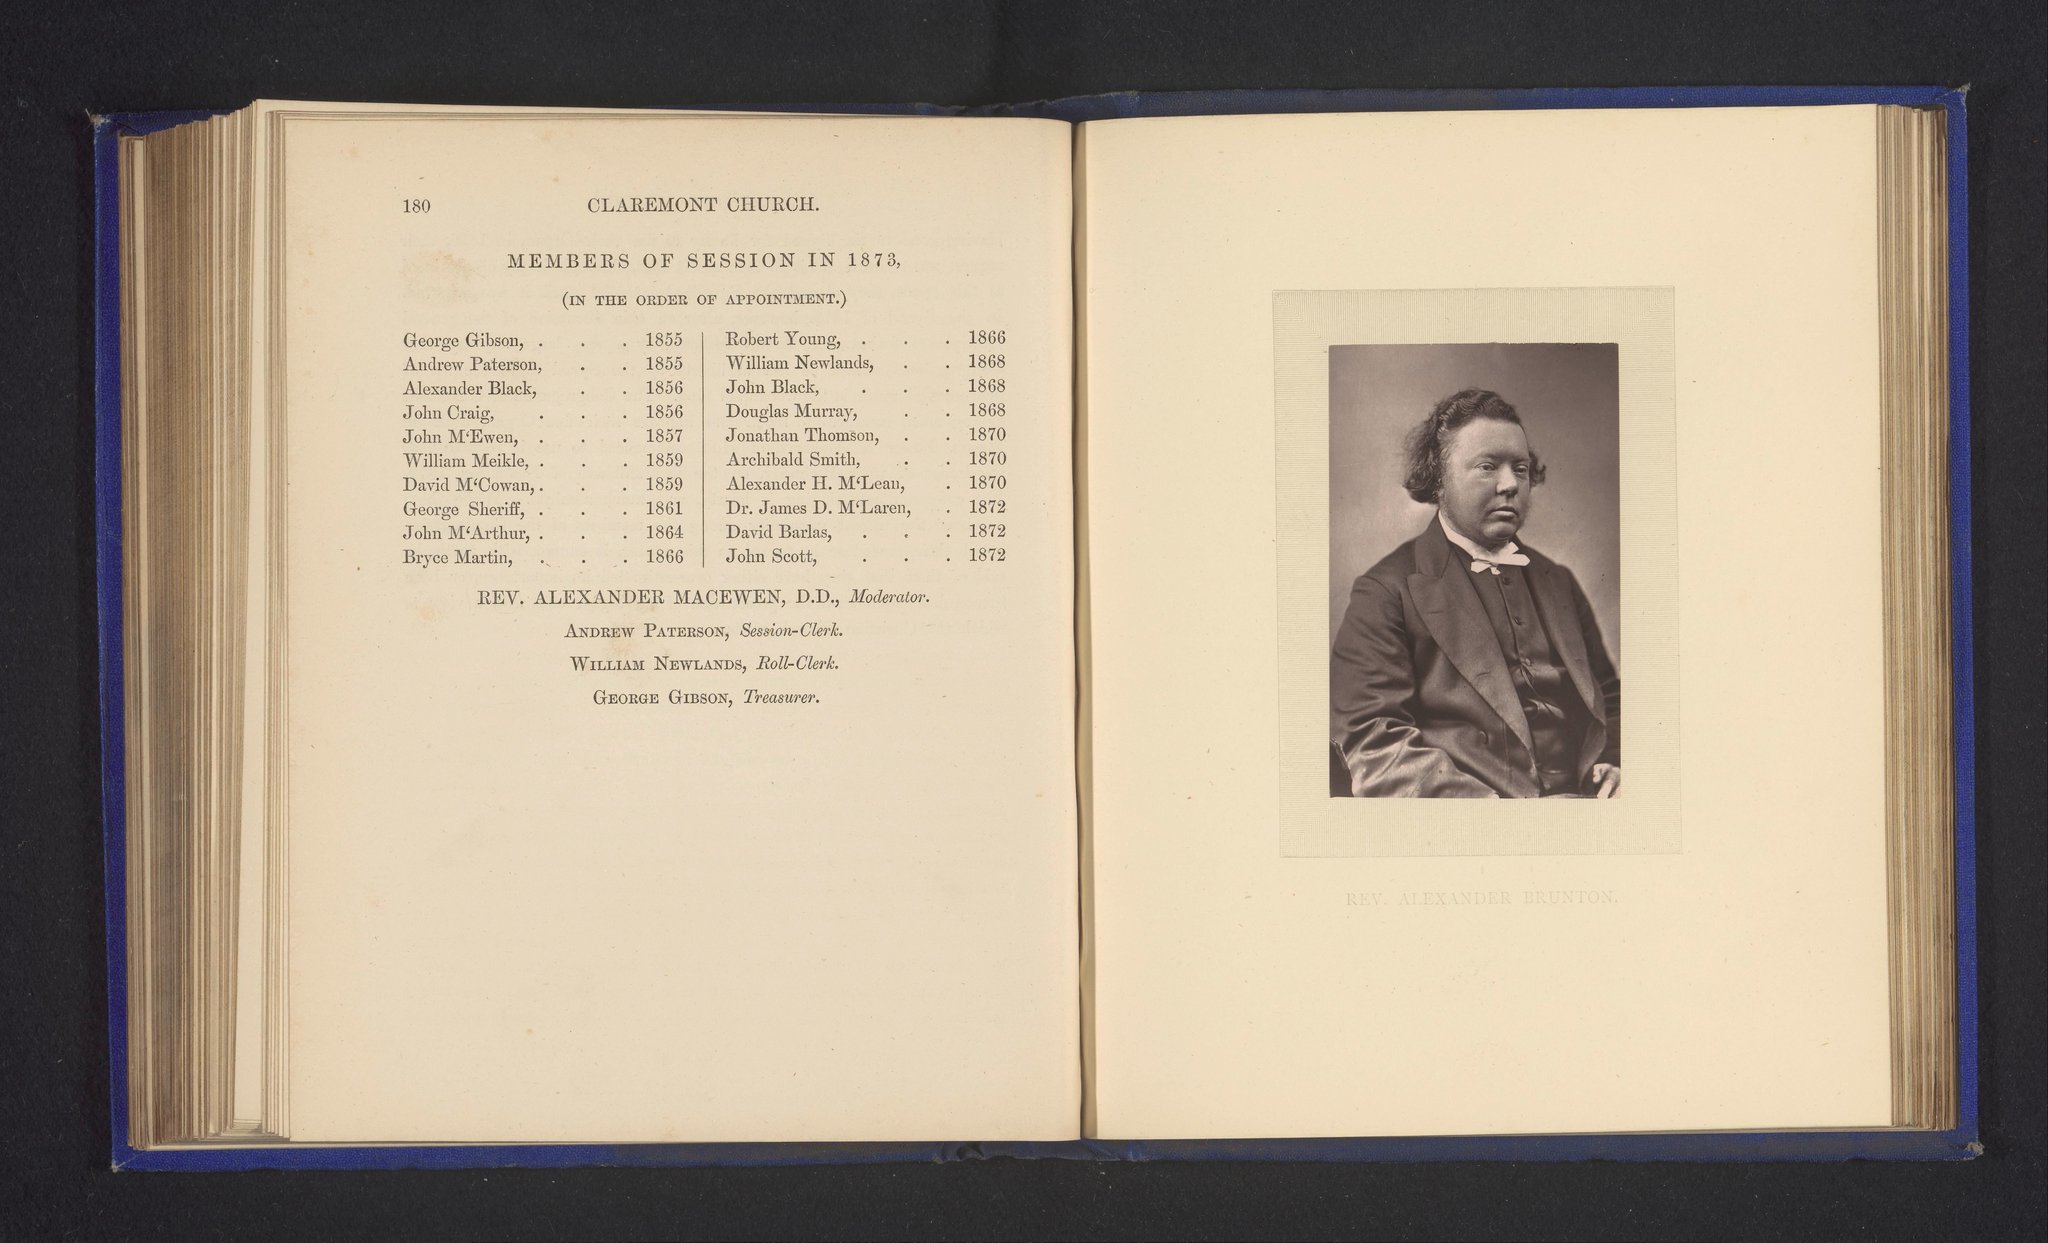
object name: photomechanical print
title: Rev. Alexander Brunton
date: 1865-1875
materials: paper, photographic support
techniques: carbon print, woodburytype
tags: functionaries and dignitaries (with name) ~ protestant churches